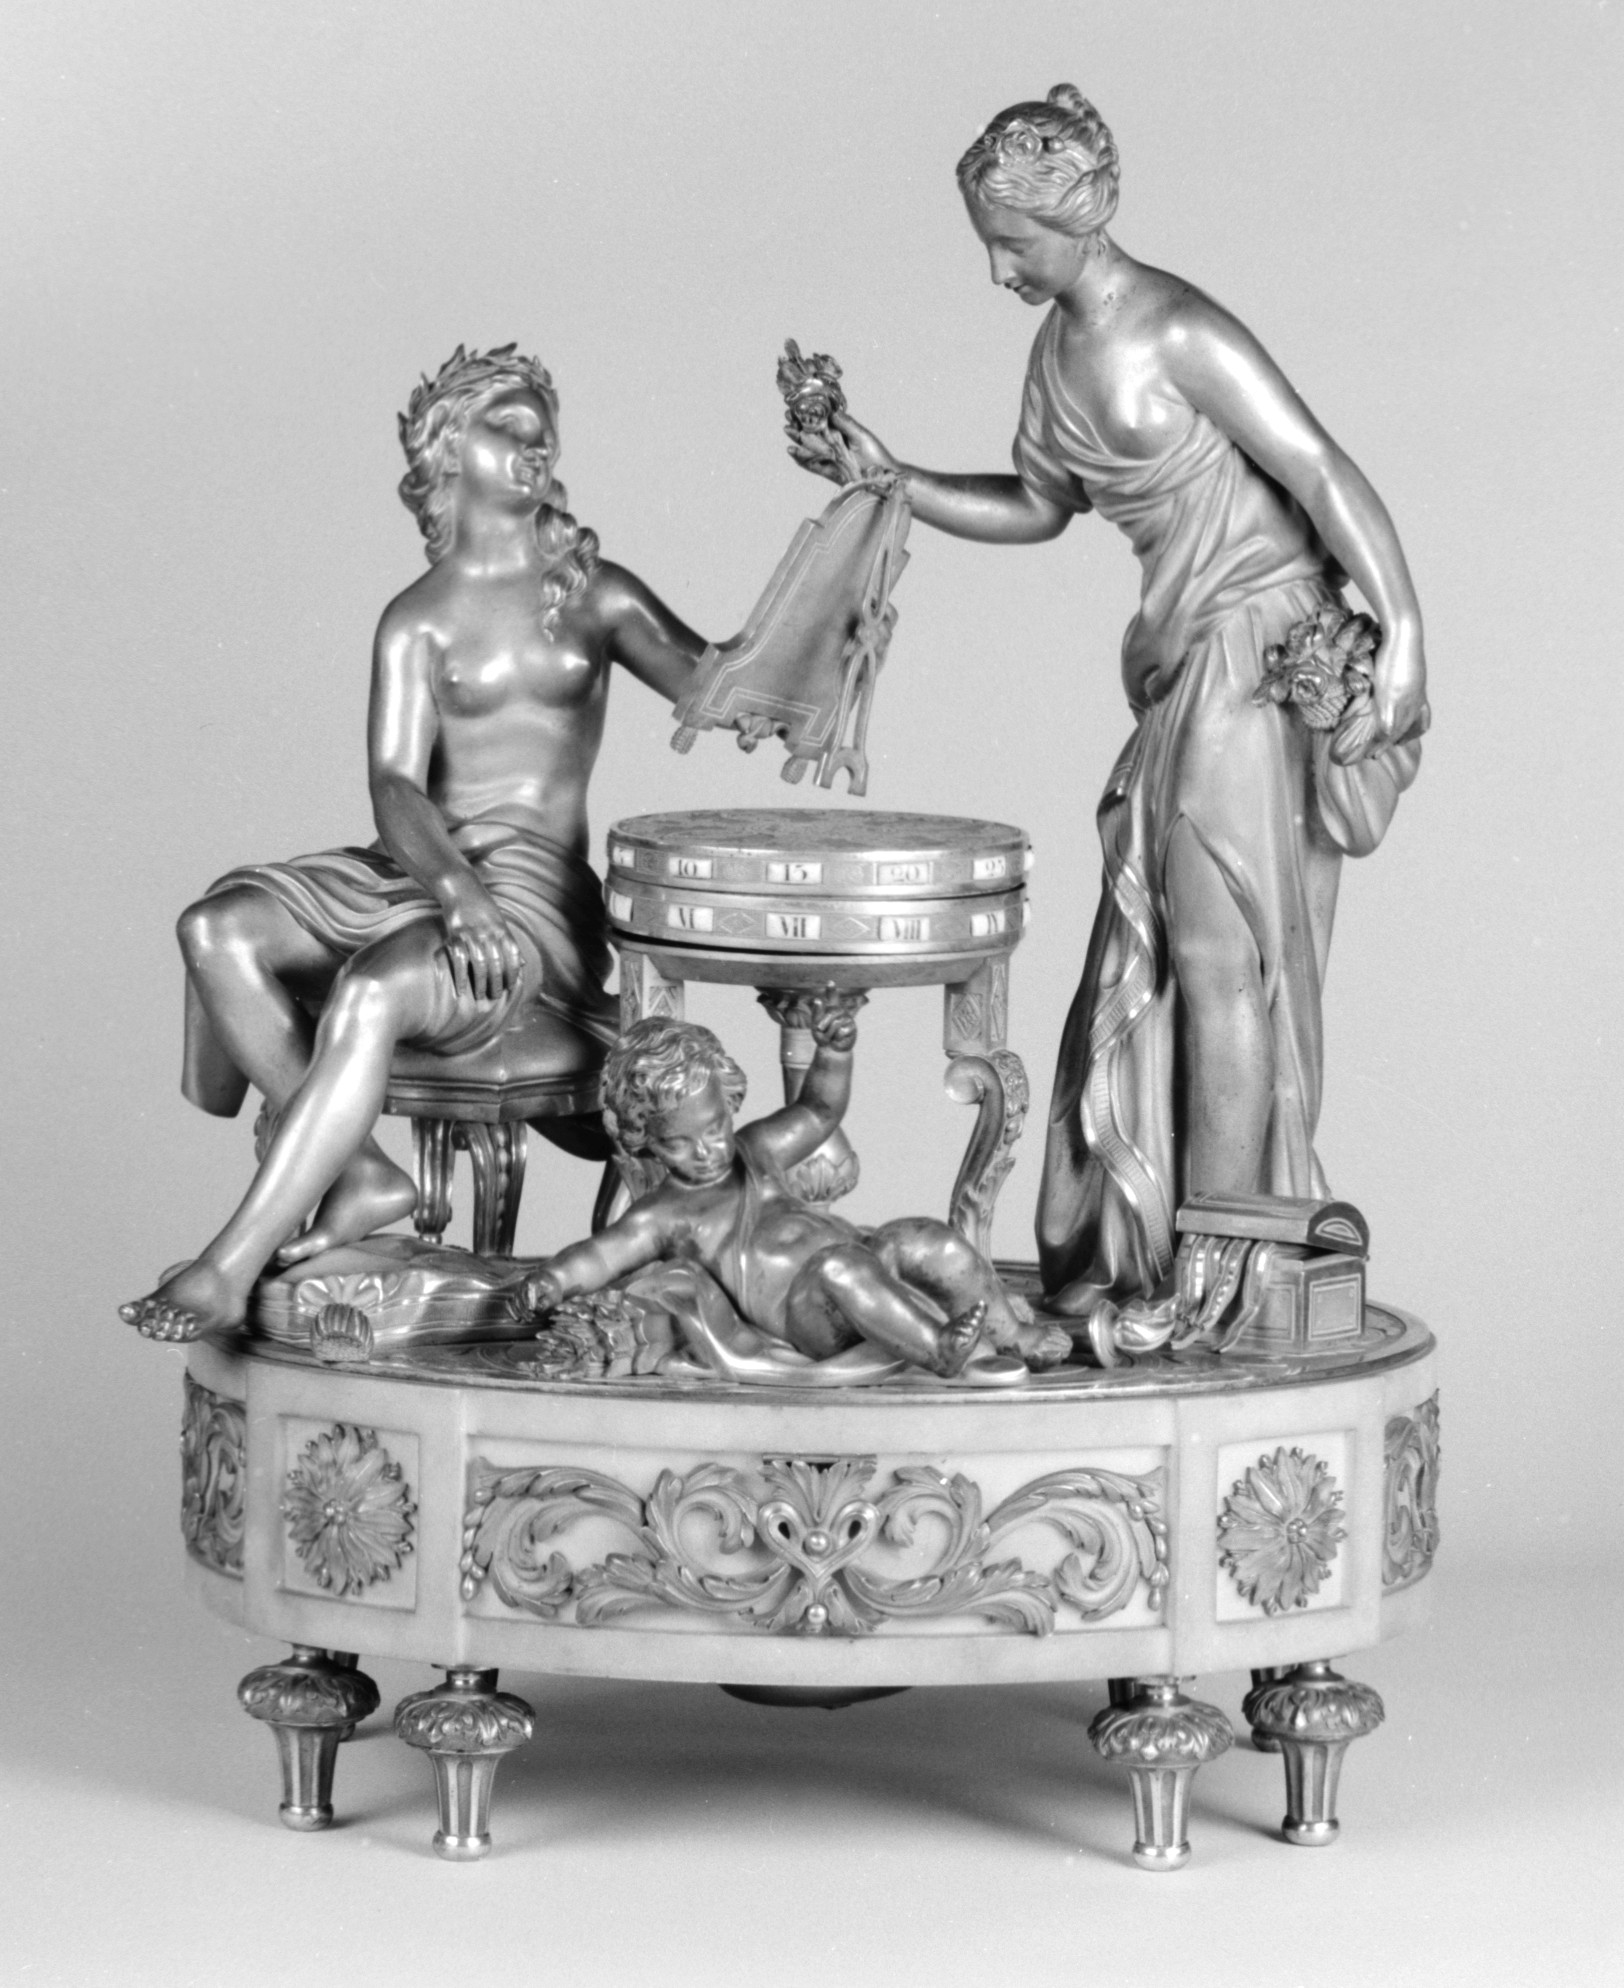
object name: mantel clock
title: The Toilette of Venus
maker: etienne-maurice falconet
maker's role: artist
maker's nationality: french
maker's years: 1716-1791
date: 1776-1800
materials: brass, bronze, enamel, marble, steel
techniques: gilding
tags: women,cupid,venus